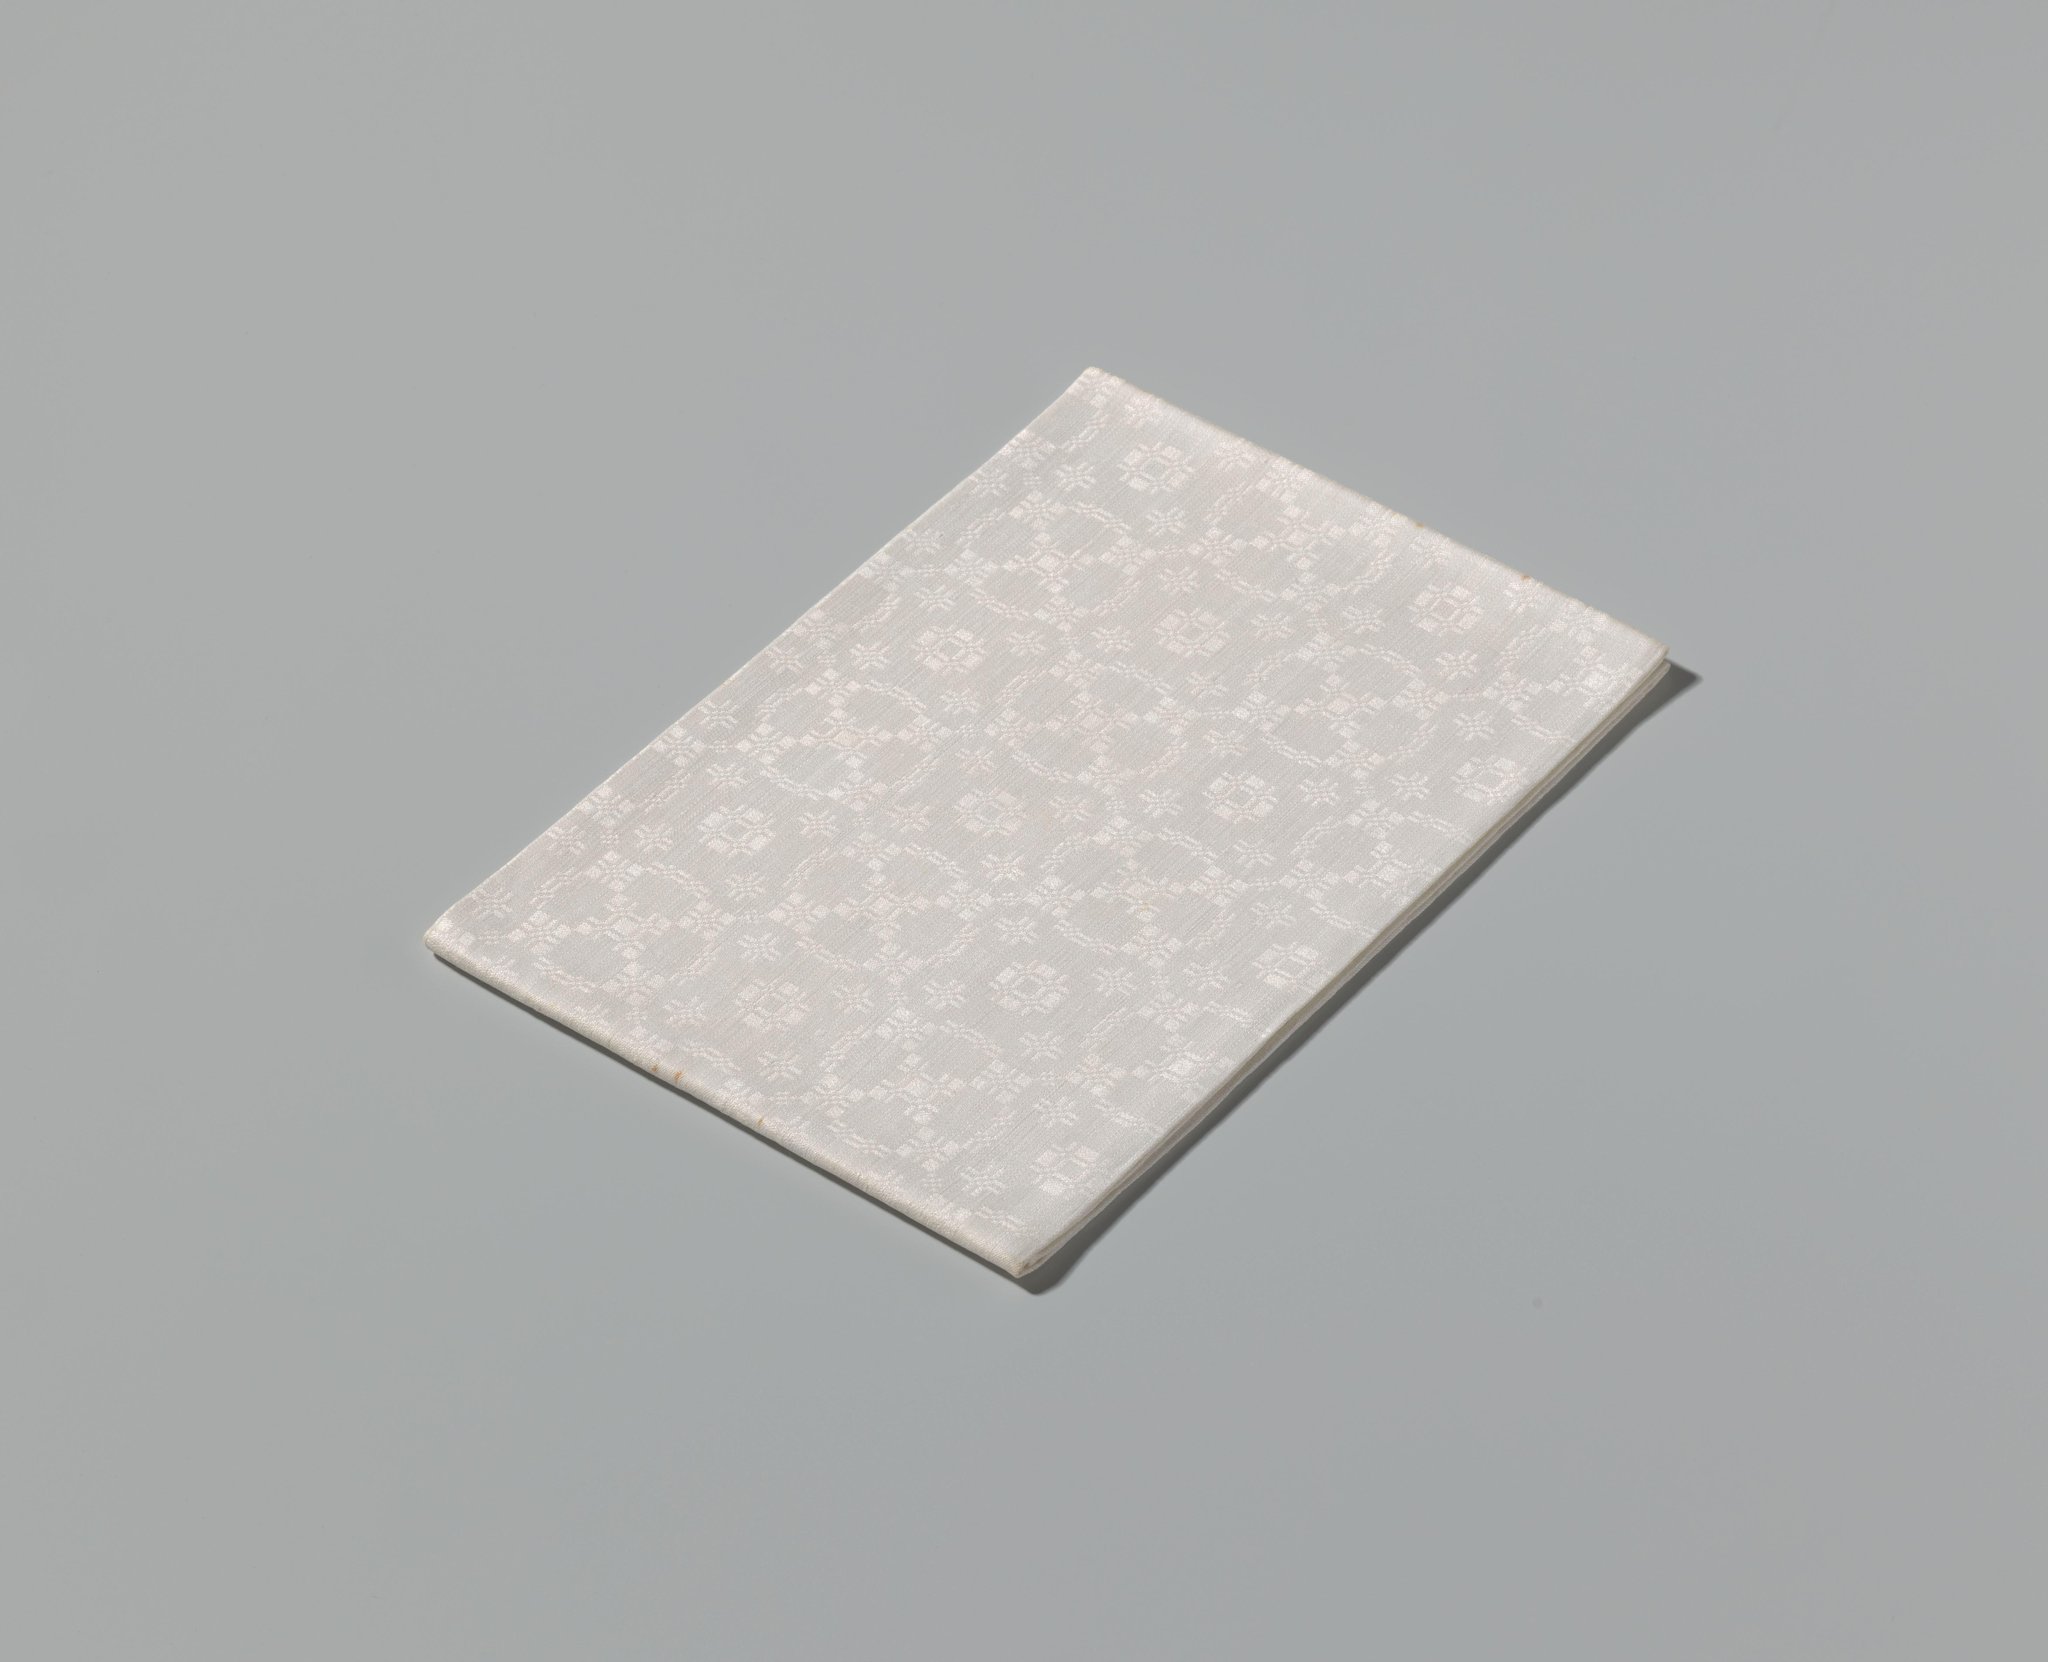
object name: napkin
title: Servet van linnen met pellenpatroon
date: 1600-1699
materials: linen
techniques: peeled fabric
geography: netherlands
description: wit linnen servet met een pellen patroon, merk R WH 2oonl